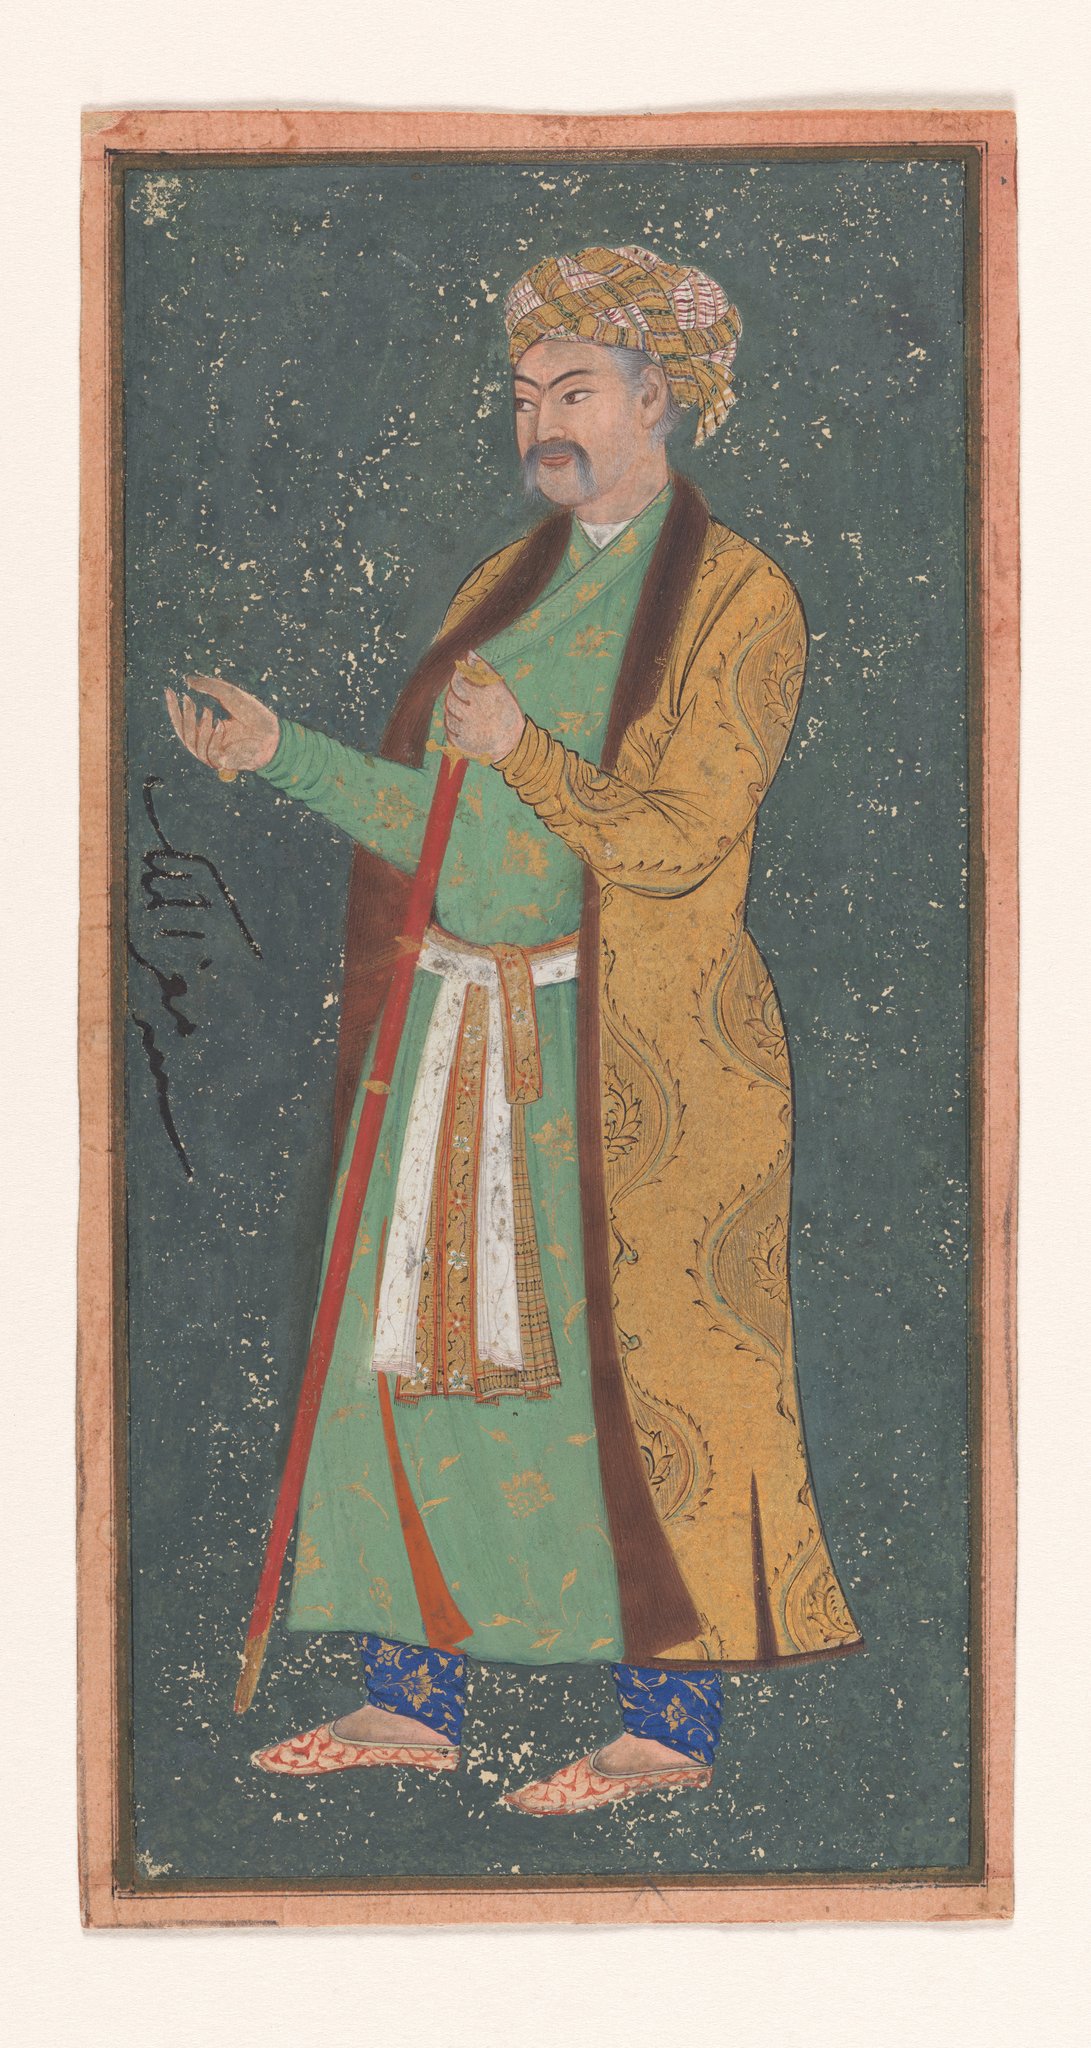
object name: illustrated single work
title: Portrait of Mu’izz al-Mulk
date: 1610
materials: gold, paper, shell, watercolor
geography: india